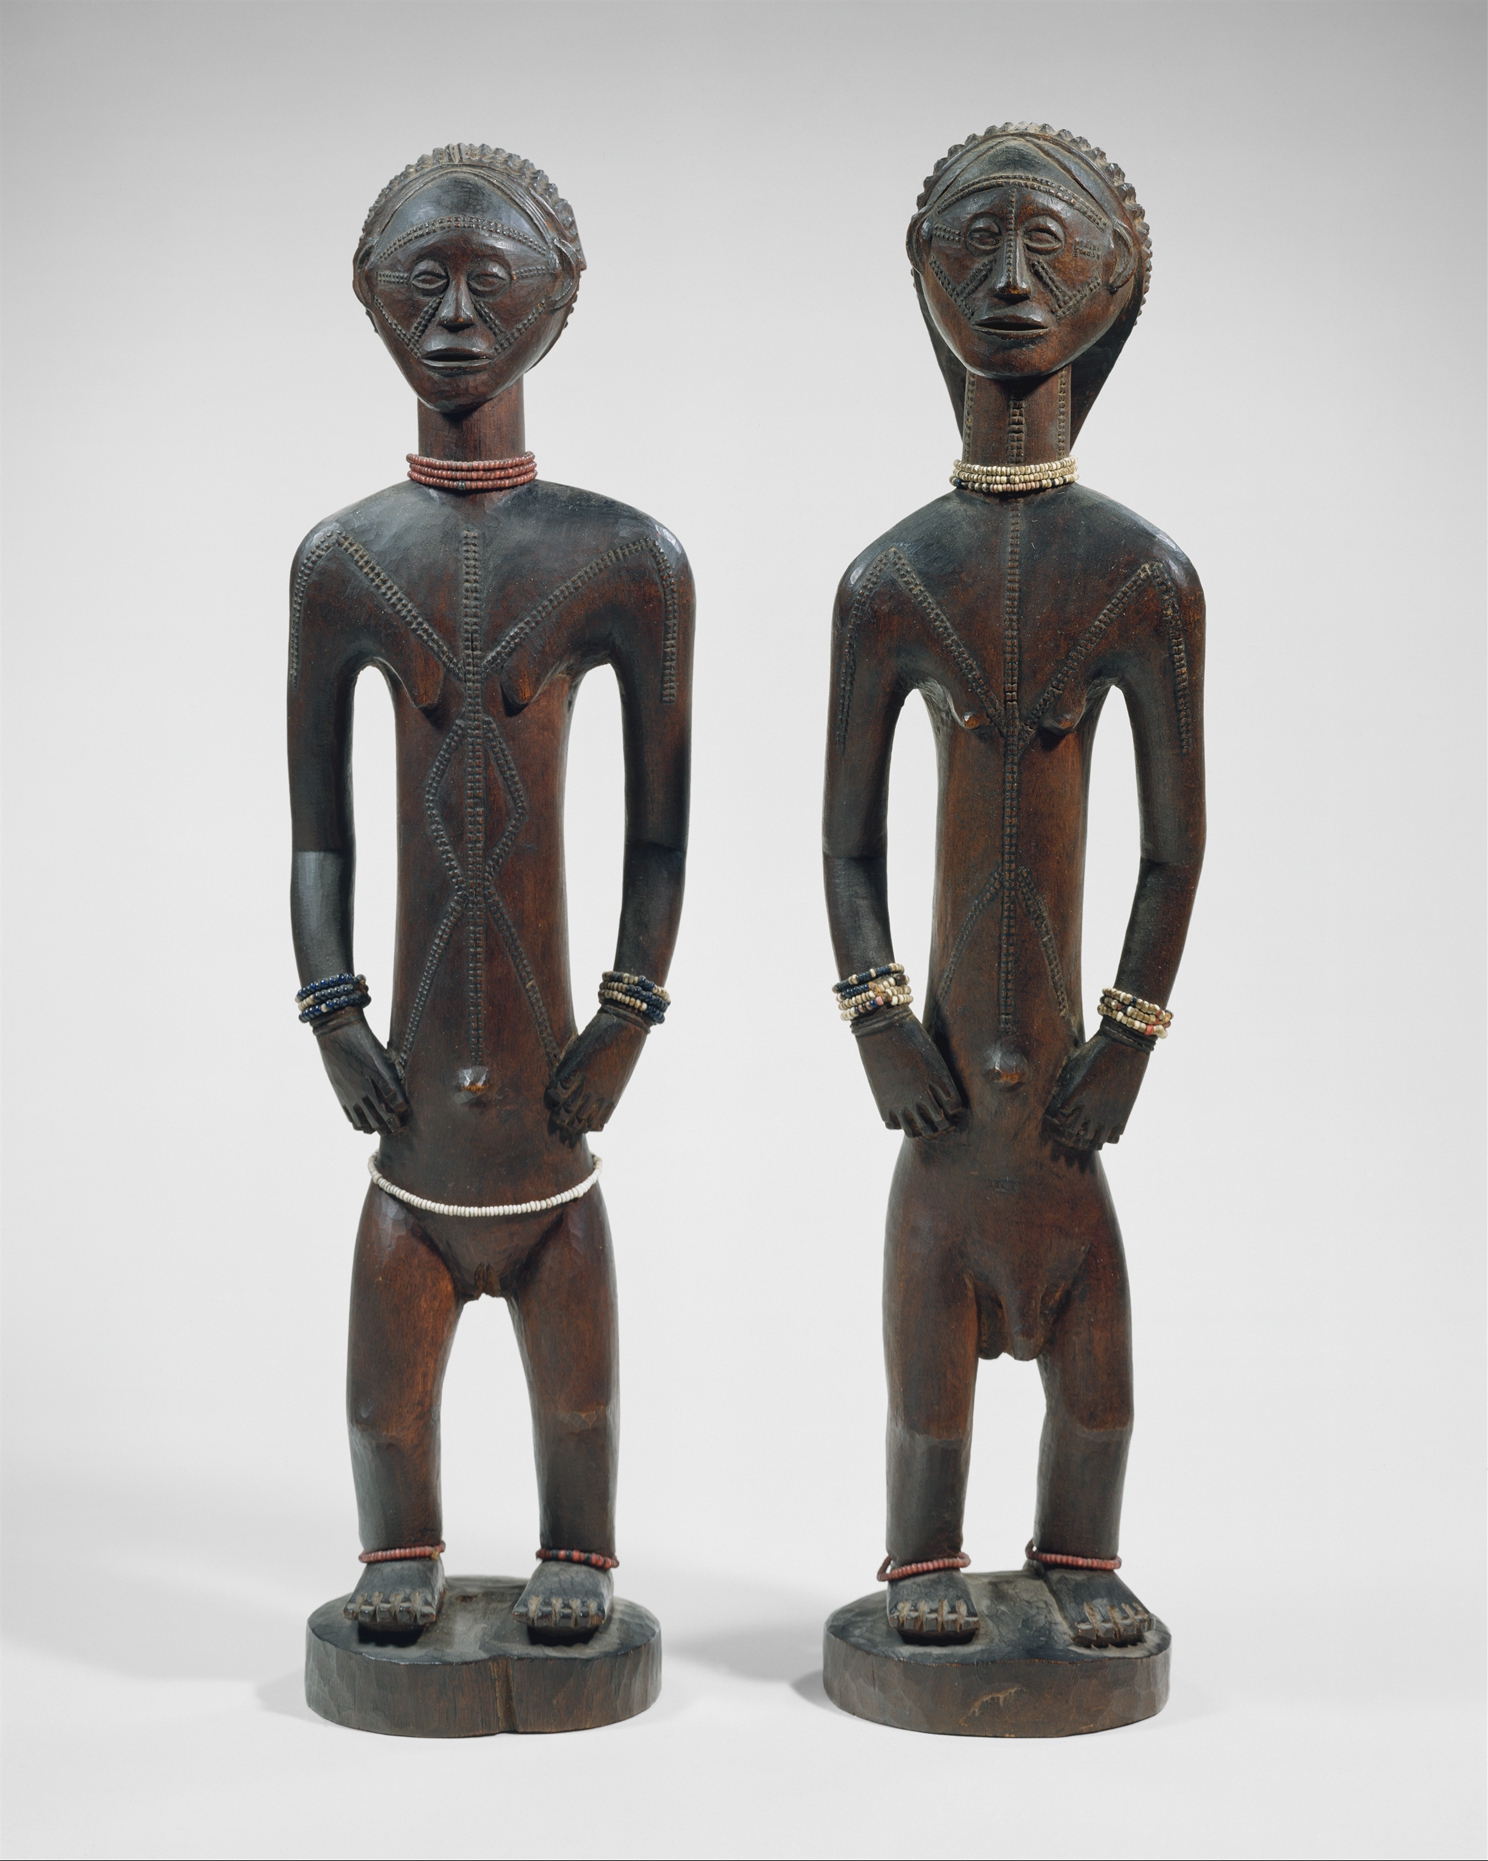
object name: female figure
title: Standing Male and Female Figures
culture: tabwa peoples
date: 1701-1900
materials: wood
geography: democratic republic of the congo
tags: men,women